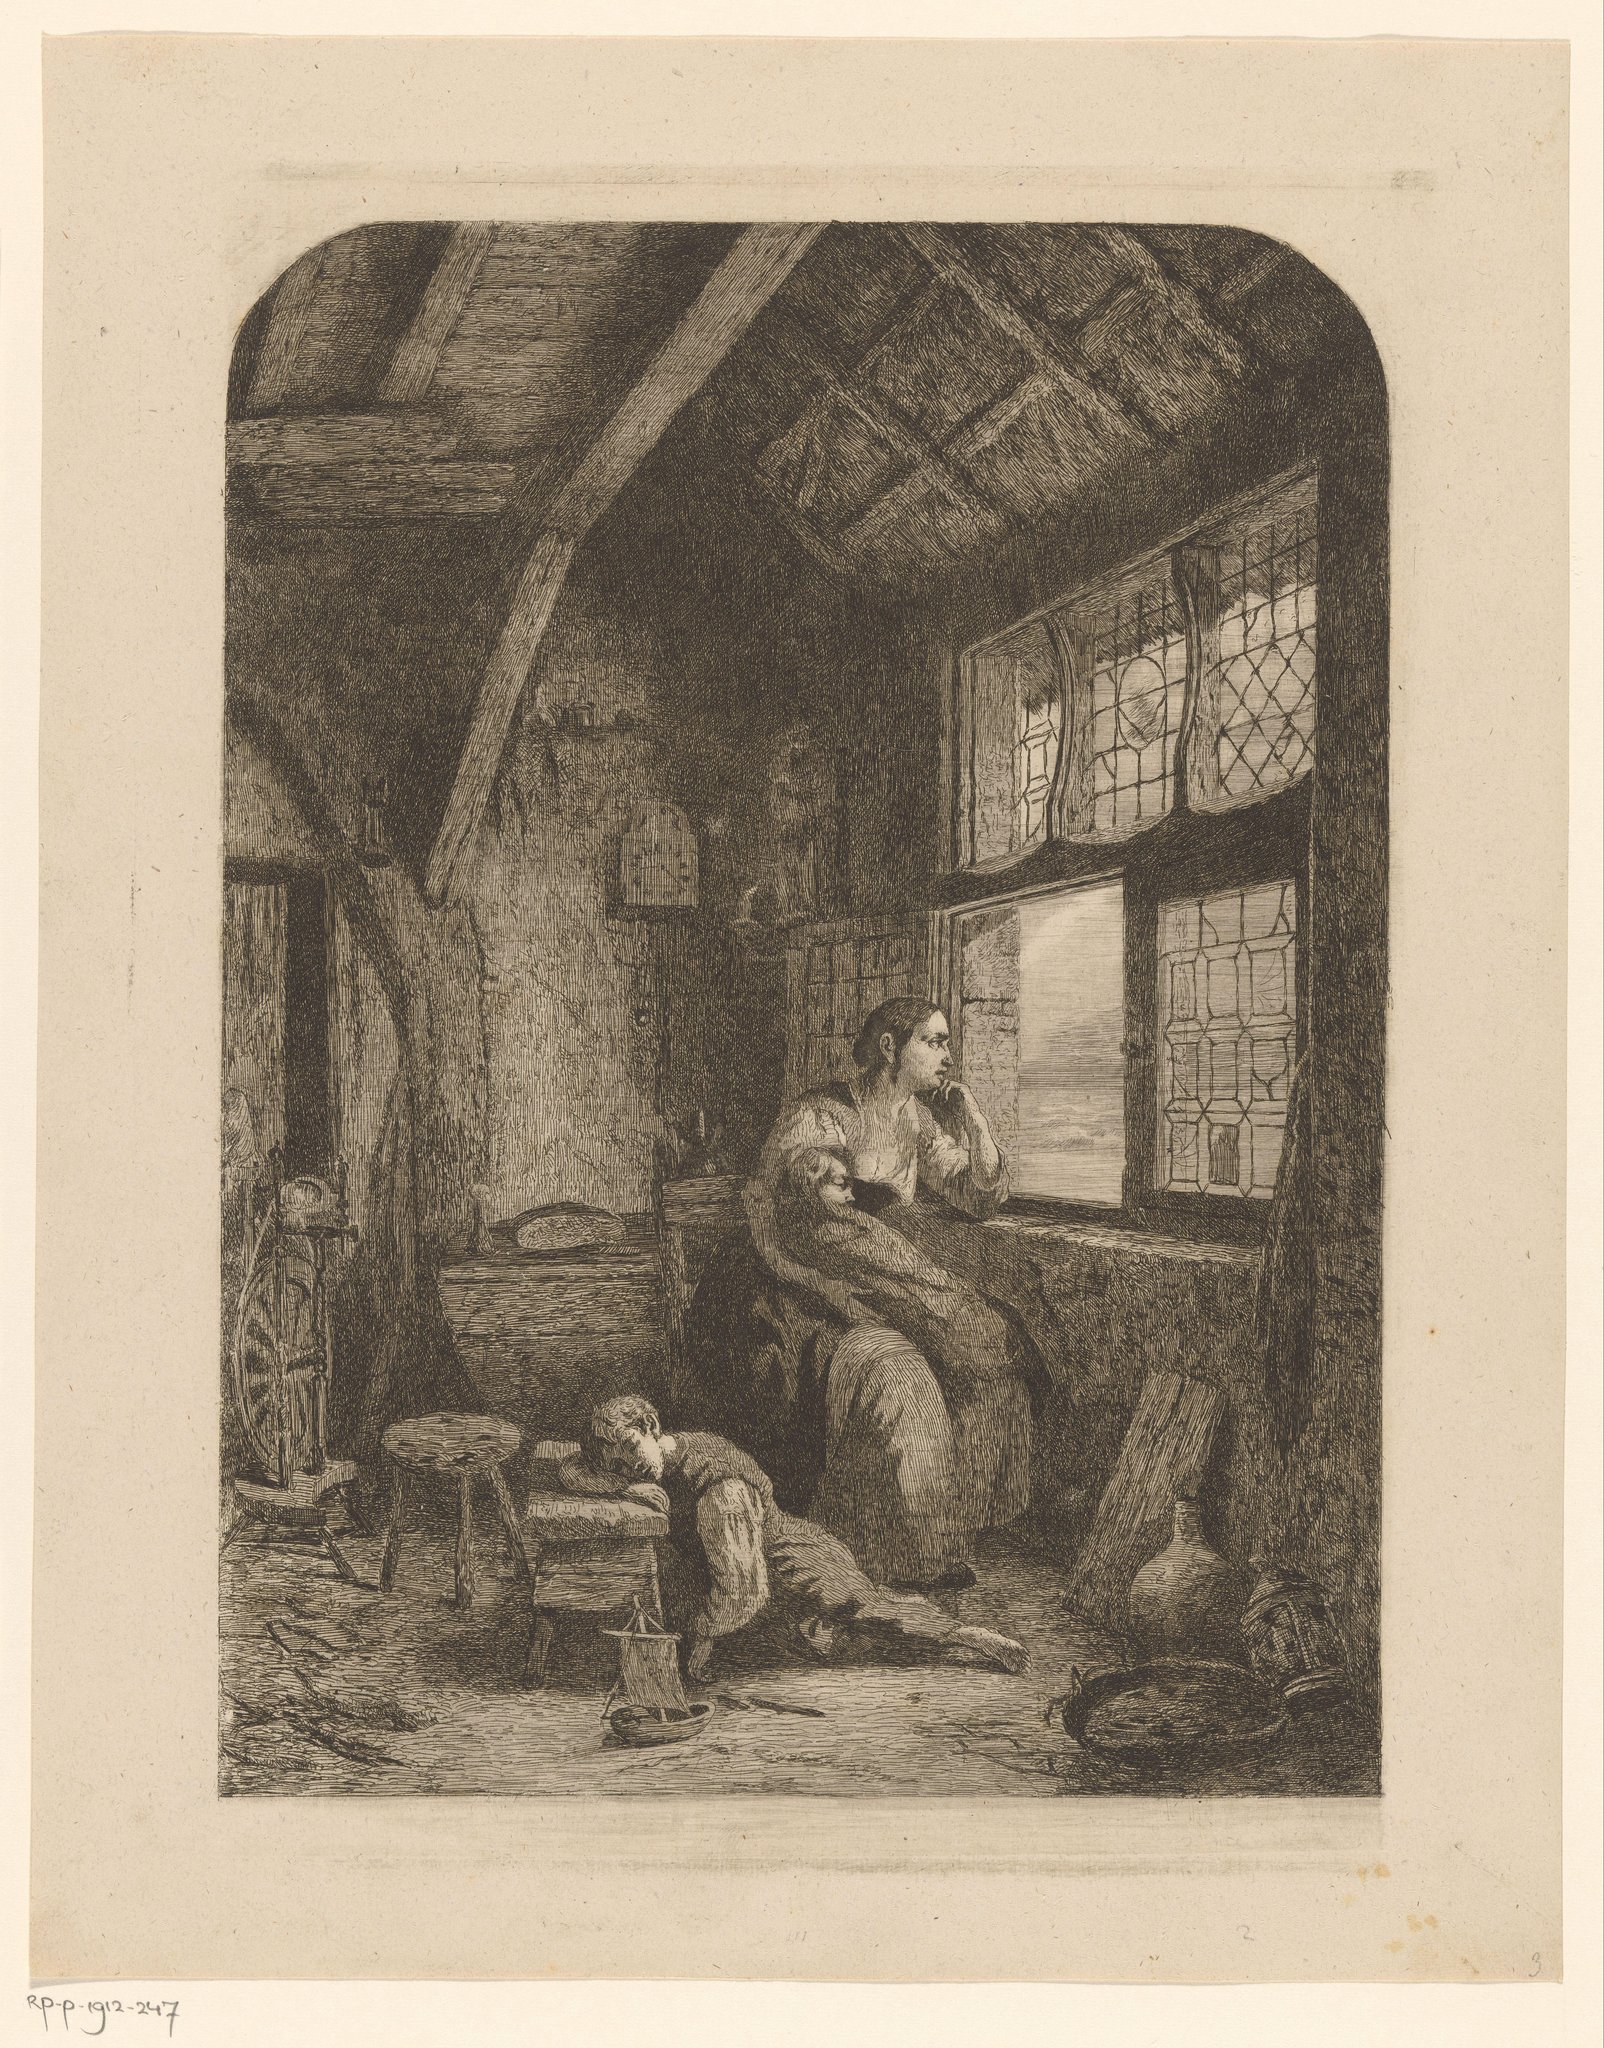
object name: print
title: Vrouw met twee slapende kinderen wachtend bij een open raam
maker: willem linnig (i)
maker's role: print maker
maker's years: 1819-1885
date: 1856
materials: paper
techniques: etching, intaglio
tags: mother and child(ren), woman and child(ren) (family group)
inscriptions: annotation: ‘3me état / il existe 2 exemplaires de cet état’, collector's mark: Lugt 2228, collector's mark: Lugt 1485